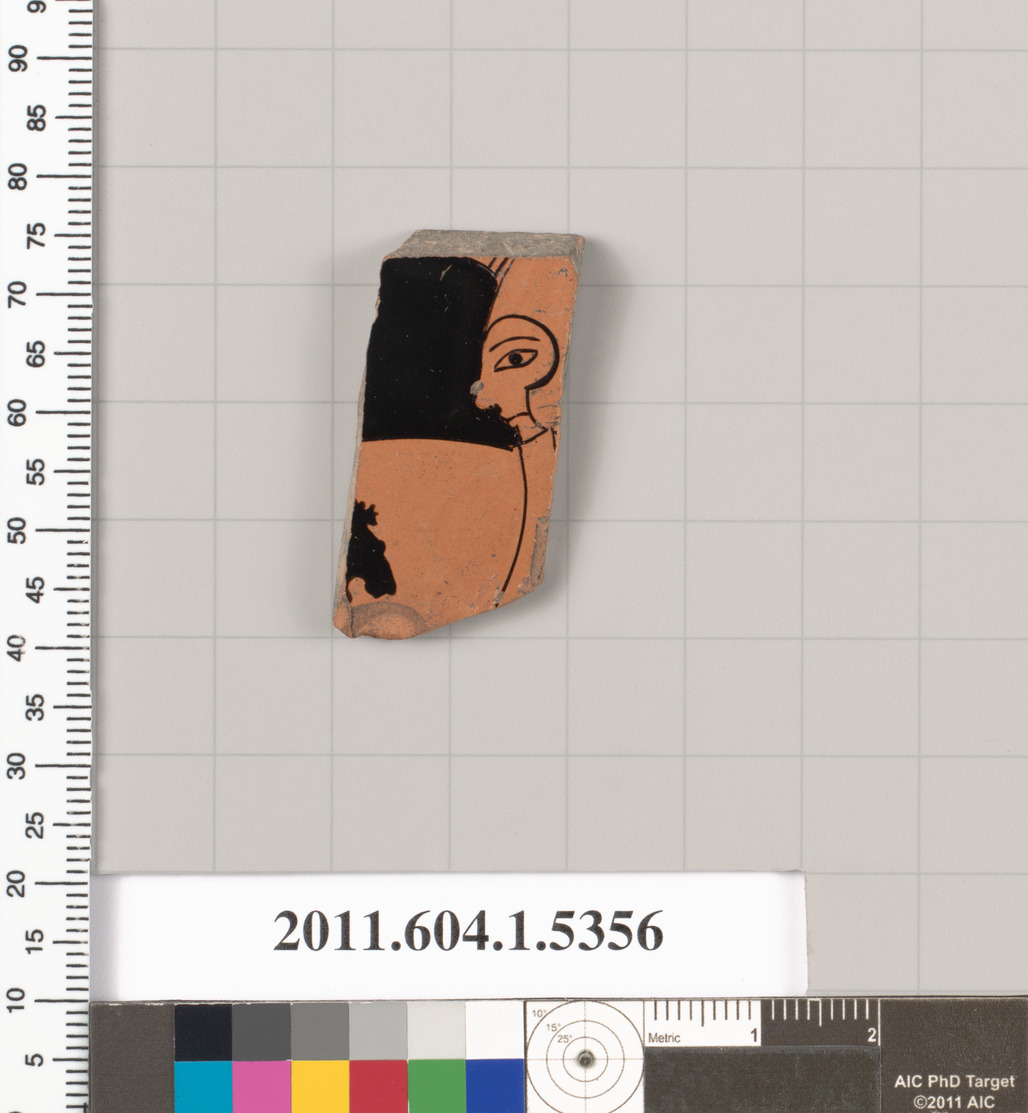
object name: kylix fragment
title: Terracotta fragment of a kylix (drinking cup)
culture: greek, attic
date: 520-500 BCE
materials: terracotta